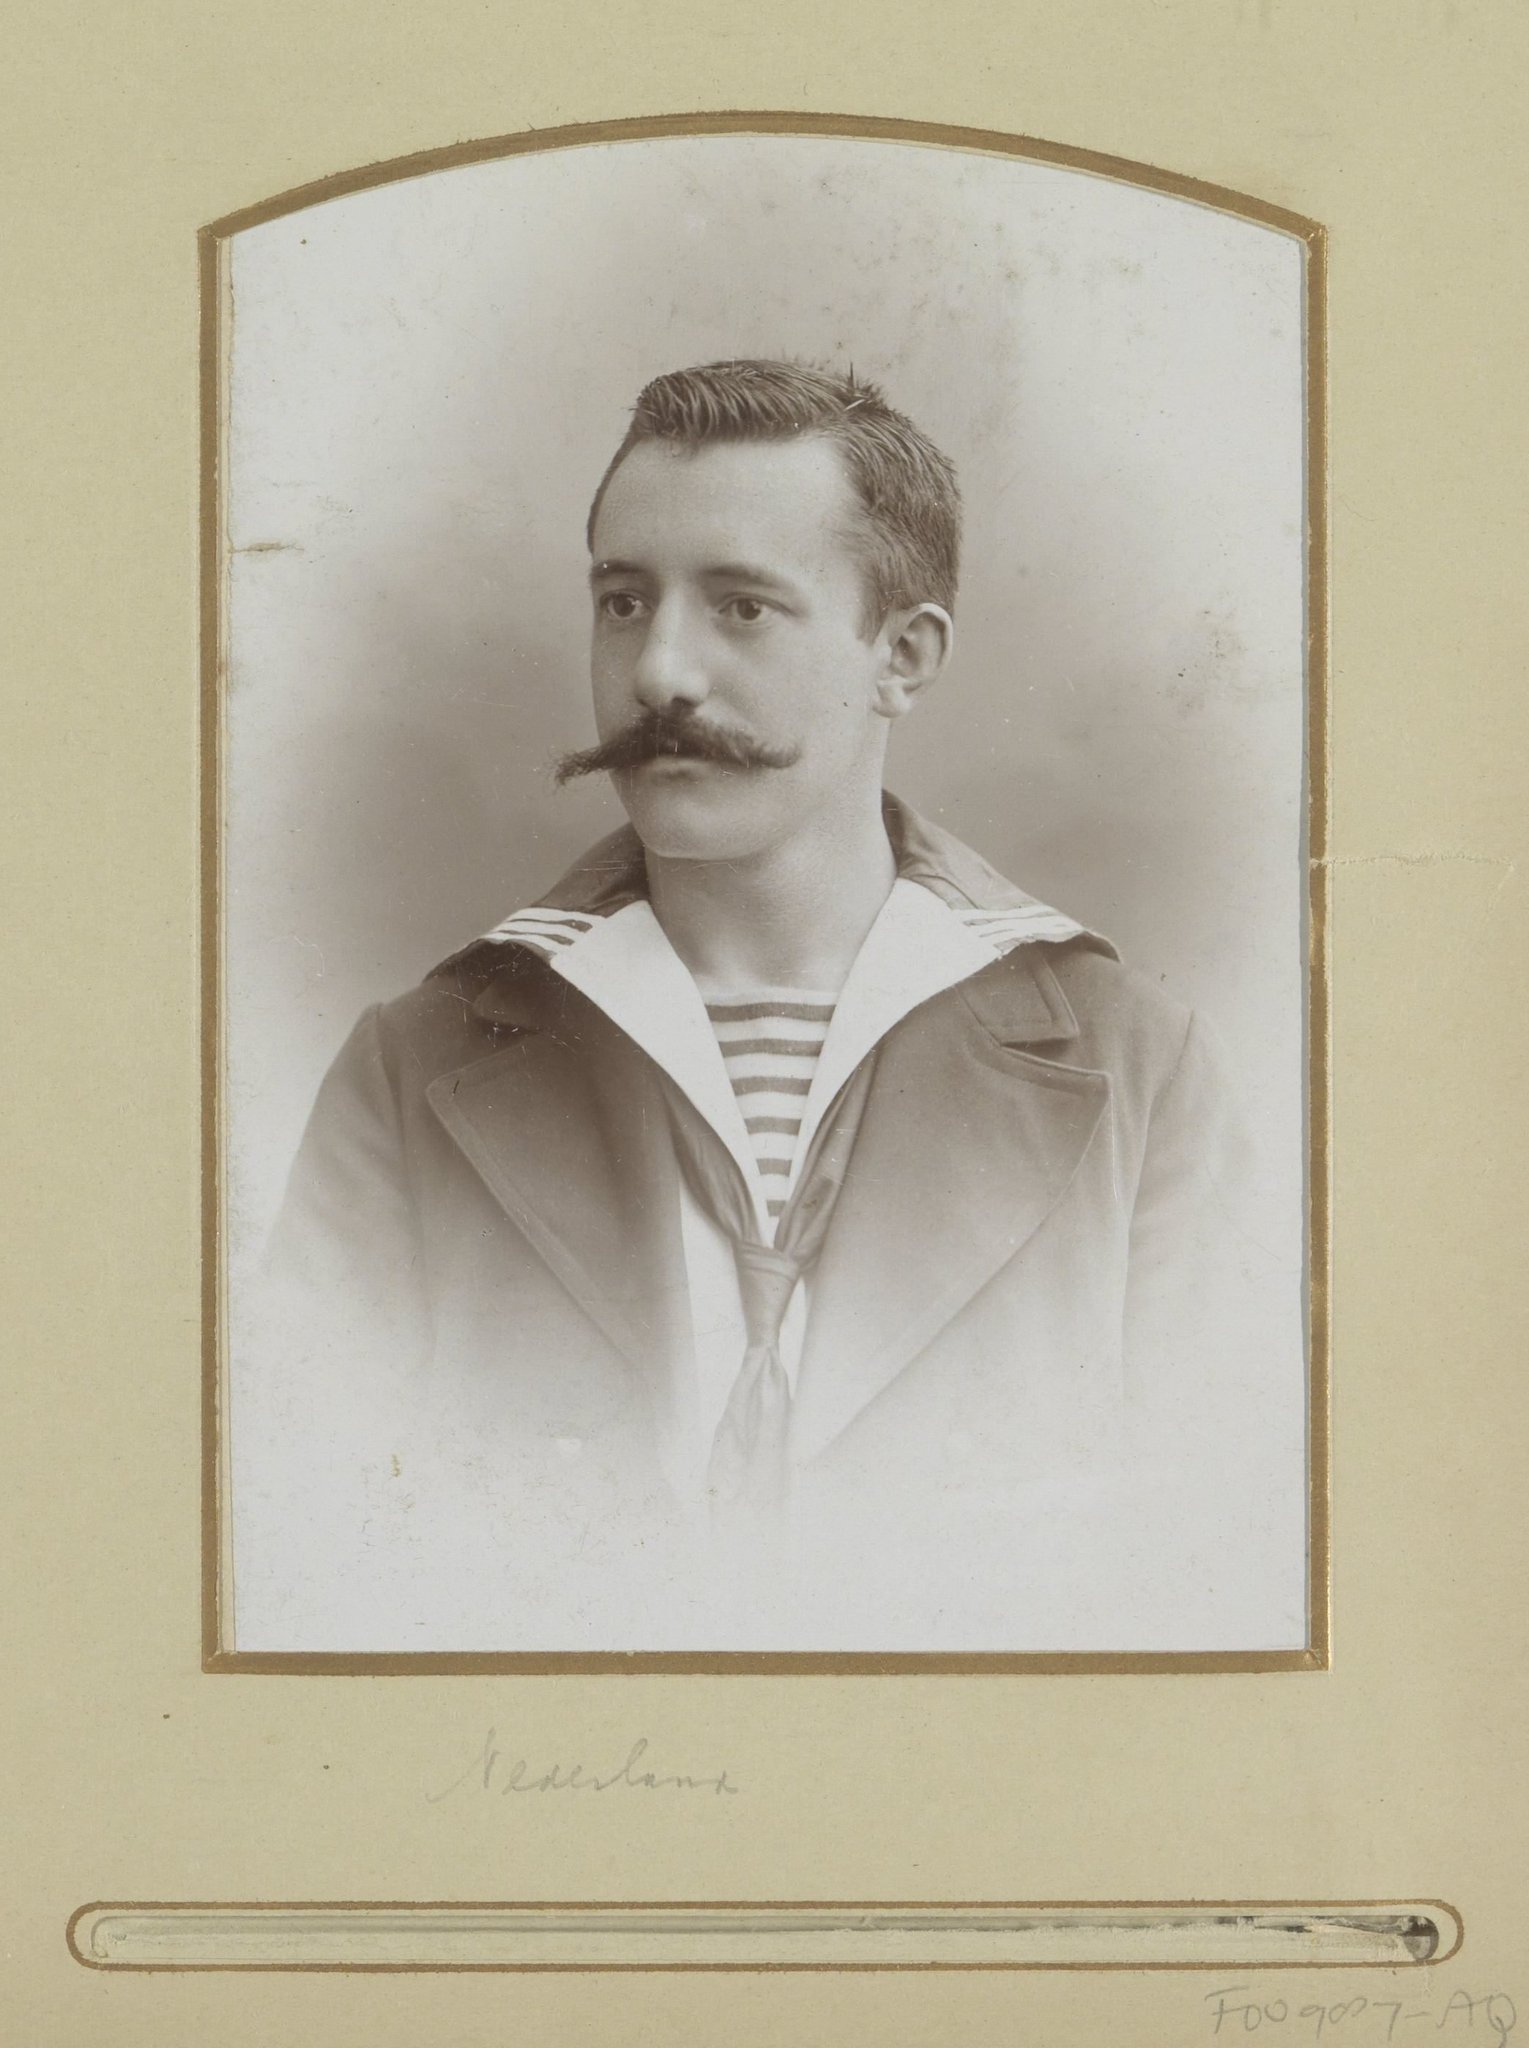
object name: photograph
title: Portret van een (vermoedelijk) Nederlandse matroos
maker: machiel hendricus laddé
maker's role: fotograaf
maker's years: 1866-1932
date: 1892-1906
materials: cardboard, paper, photographic support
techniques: collodion silver print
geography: amsterdam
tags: moustache, navy, warfare; military affairs, (military) uniforms, division of armed forces, amsterdam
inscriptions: address: ‘Boven de firma Merkelbach & Co. Amsterdam 57-59 Nieuwendijk’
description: Onderdeel van Album met cartes-de-visite en kabinetfoto's van militairen in uniform.